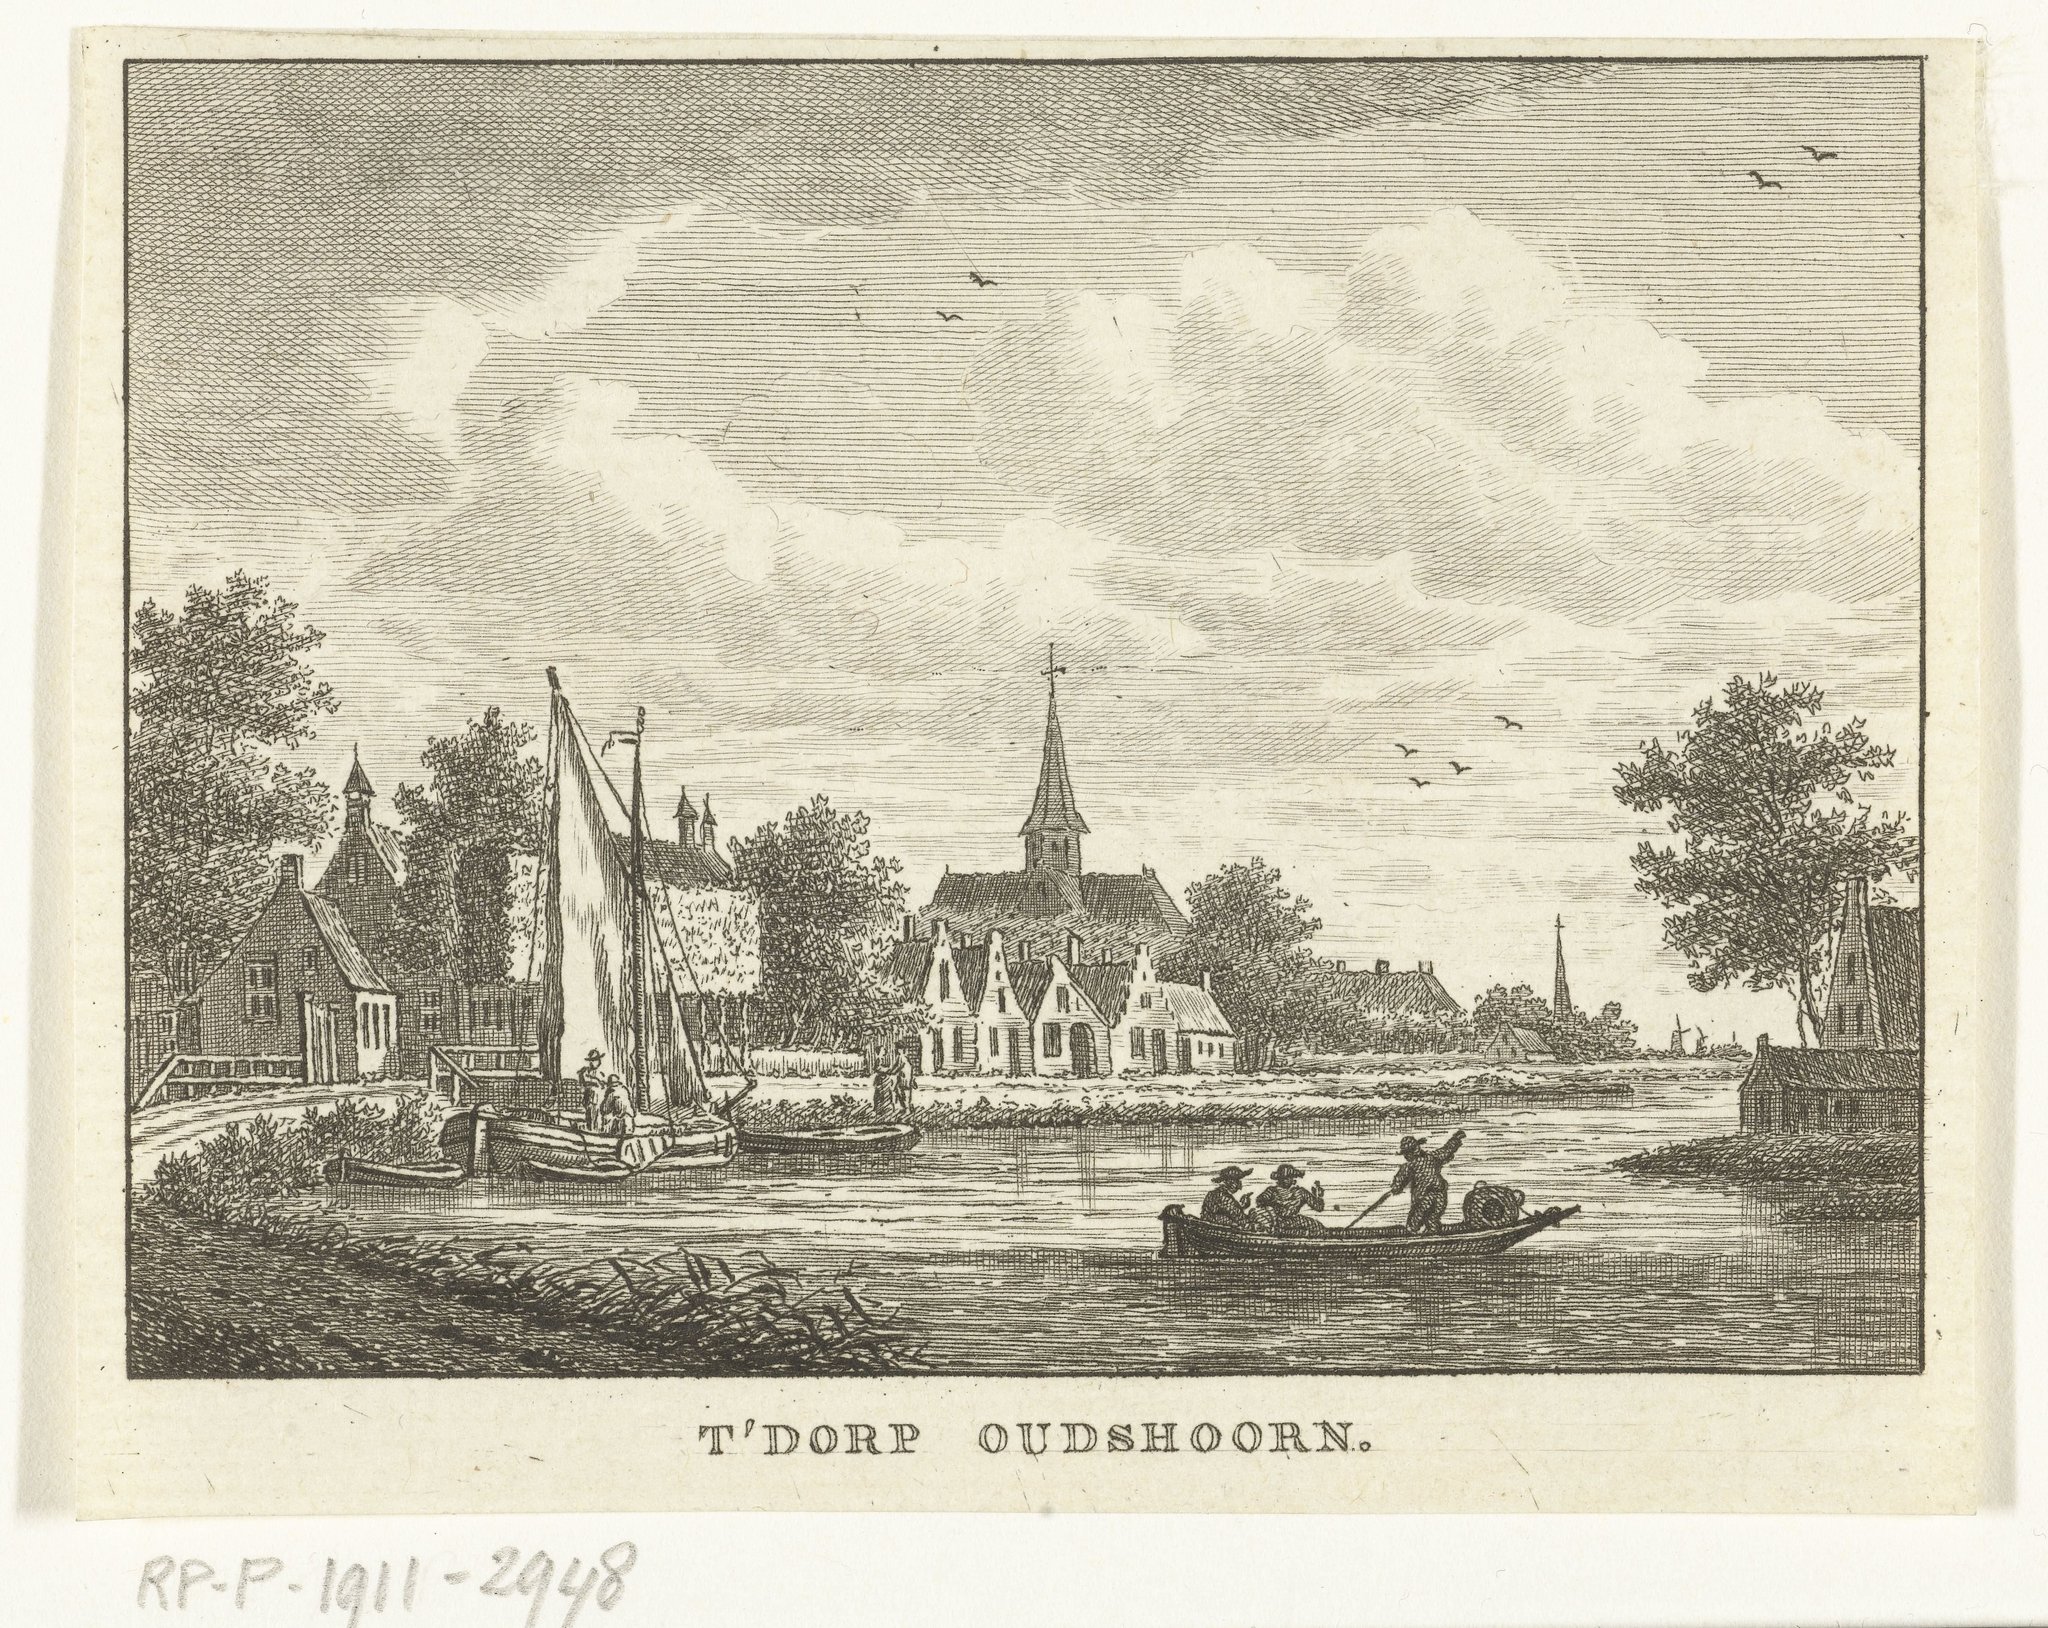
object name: print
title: Gezicht op dorp Oudshoorn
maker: carel frederik bendorp (i)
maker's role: print maker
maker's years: 1736-1814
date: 1786-1792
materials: paper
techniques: etching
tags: village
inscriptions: collector's mark: Lugt 2228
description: Prent uit: Vaderlandsche gezichten, of afbeeldingen van den tegenwoordigen staat der Vereenigde Nederlanden (…). Amsterdam: Hendrik Gartman, Willem Vermandel en Jan Willem Smit, 1786-1792. Uitgegeven in afleveringen met ieder een eigen bifolium en inhoudsopgave. Alle prenten in deze publicatie zijn gegraveerd door Carel Frederik Bendorp (I) en, in de meeste gevallen, gebaseerd op tekeningen van Jan Bulthuis.